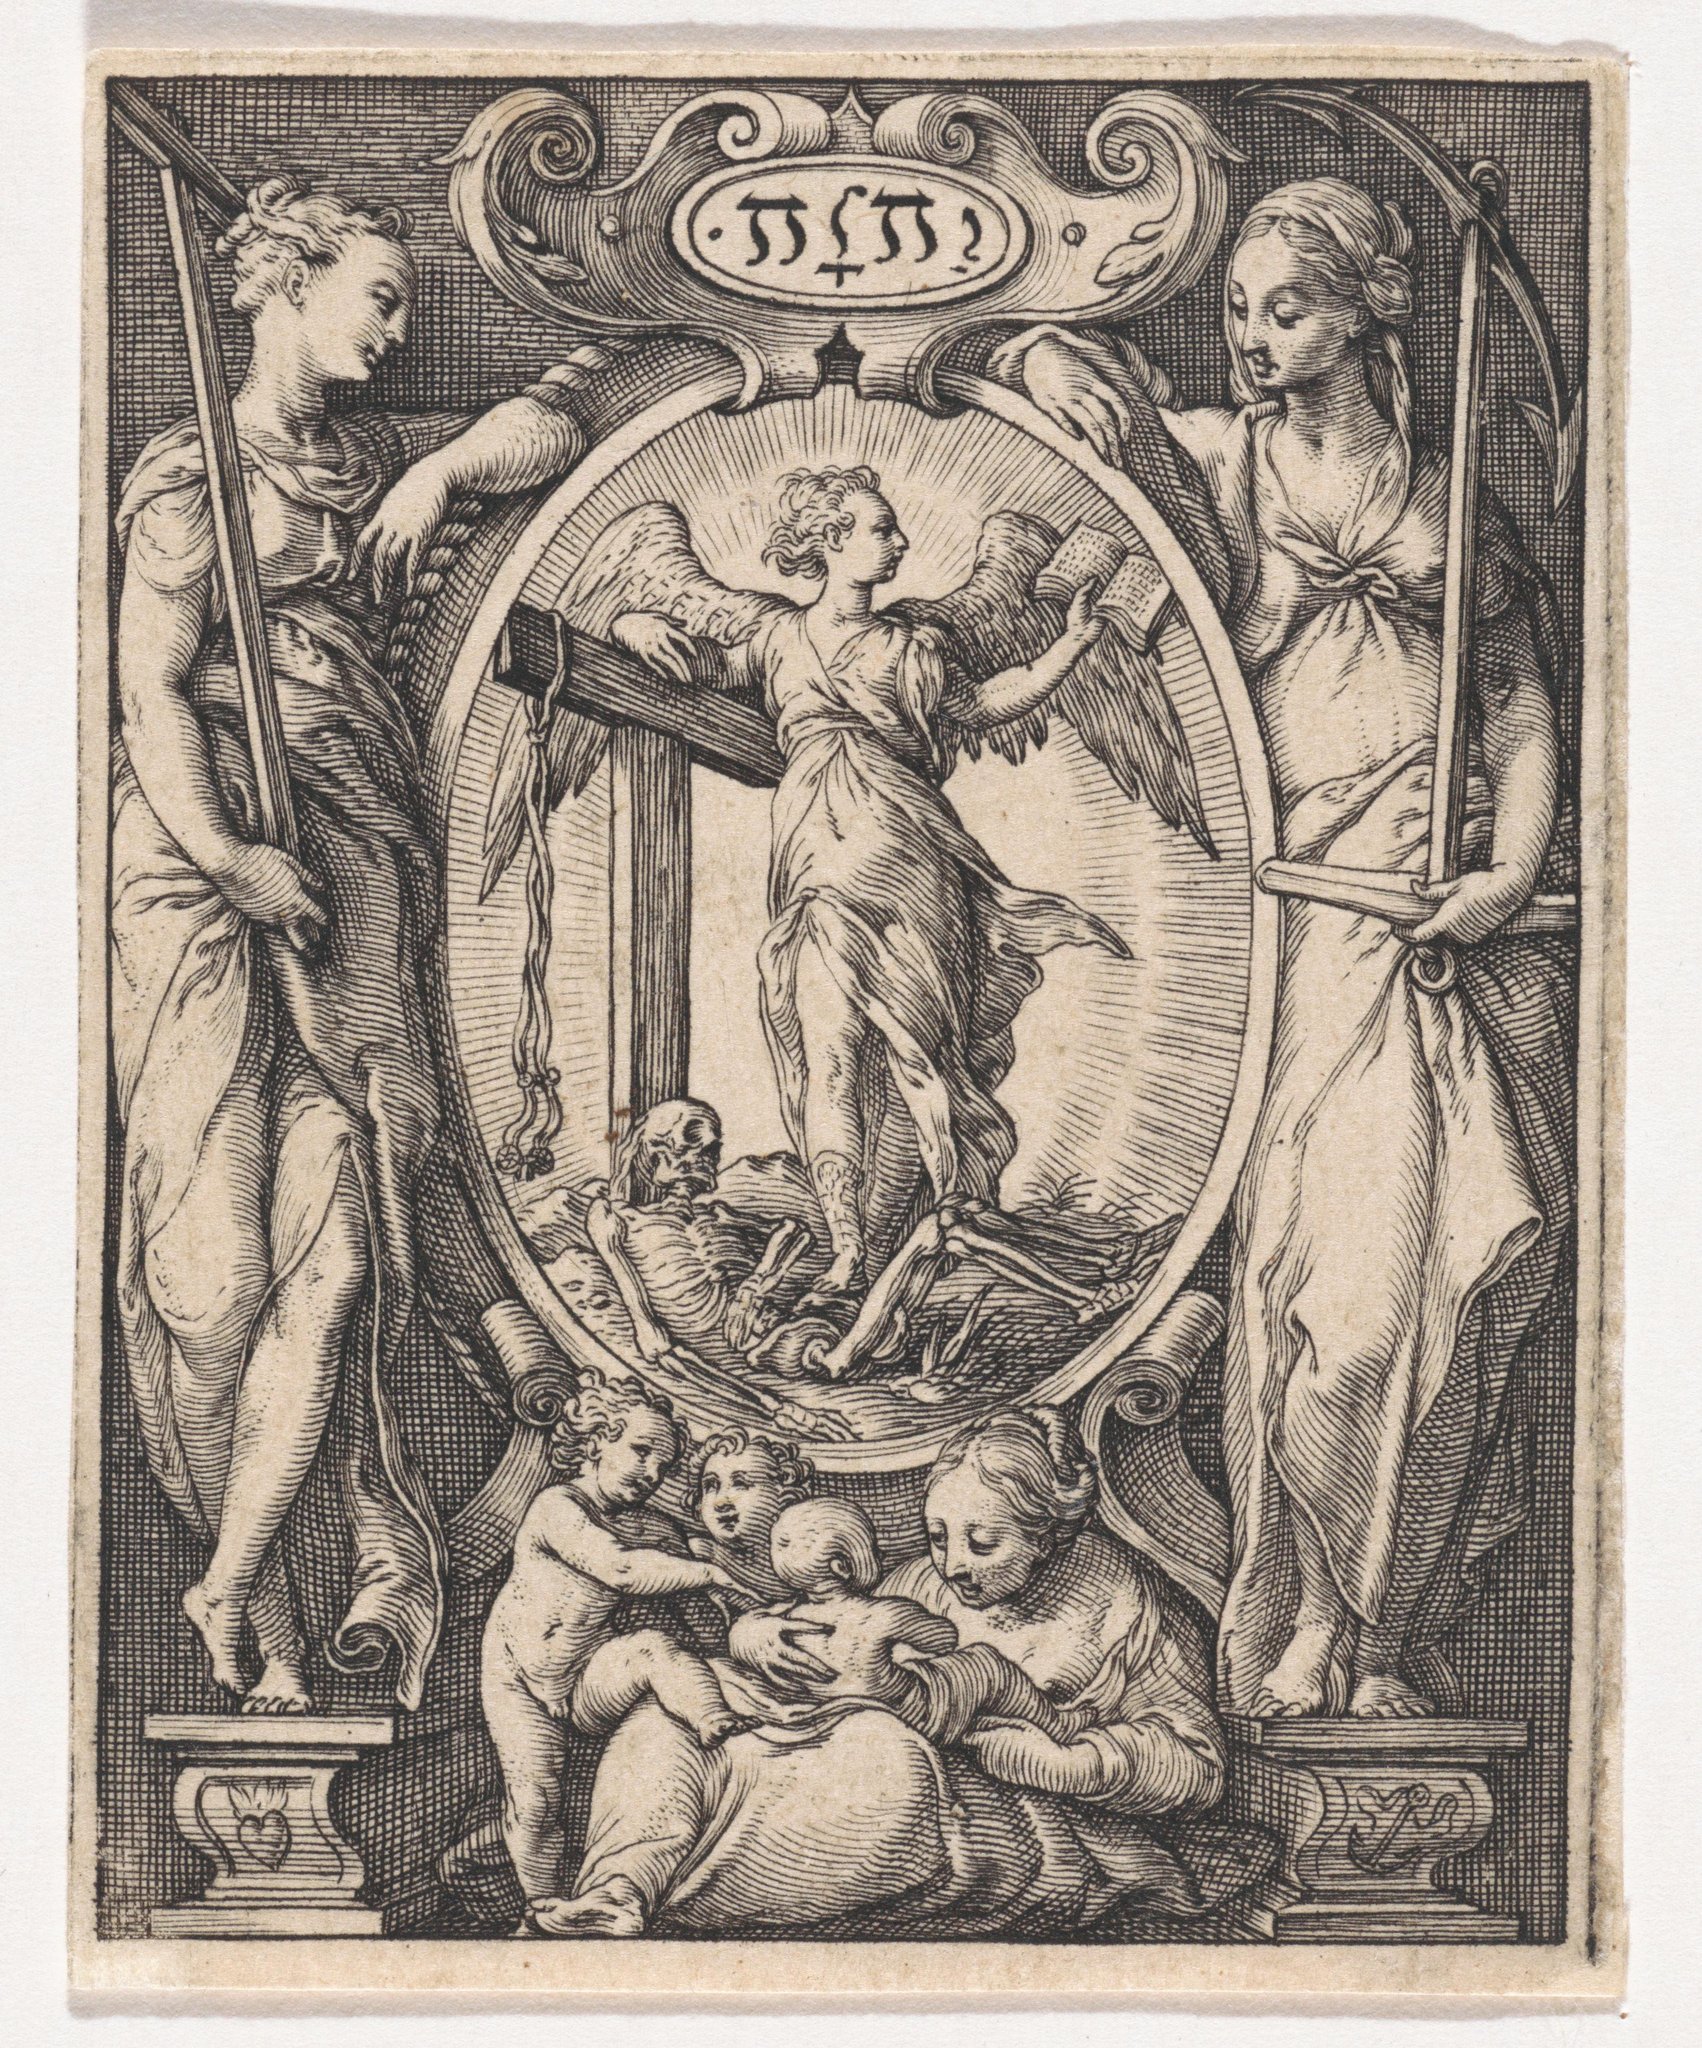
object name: print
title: Triomf van Religie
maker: wierix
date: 1550-1650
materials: paper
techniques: engraving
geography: antwerp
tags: the three theological virtues, death as skeleton, allegorical representations ~ religion; 'religione', 'religione de ss. mauritio e lazaro', 'religione vera christiana' (ripa)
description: De gevleugelde Religie staat naast het kruis en vertrapt de Dood. De voorstelling is gevat in een ovale omlijsting bekroond met het tetragram in een cartouche. Rond de omlijsting de vrouwelijke personificaties van Geloof (met kruis), Hoop (met anker) en Liefde (met kleine kinderen).